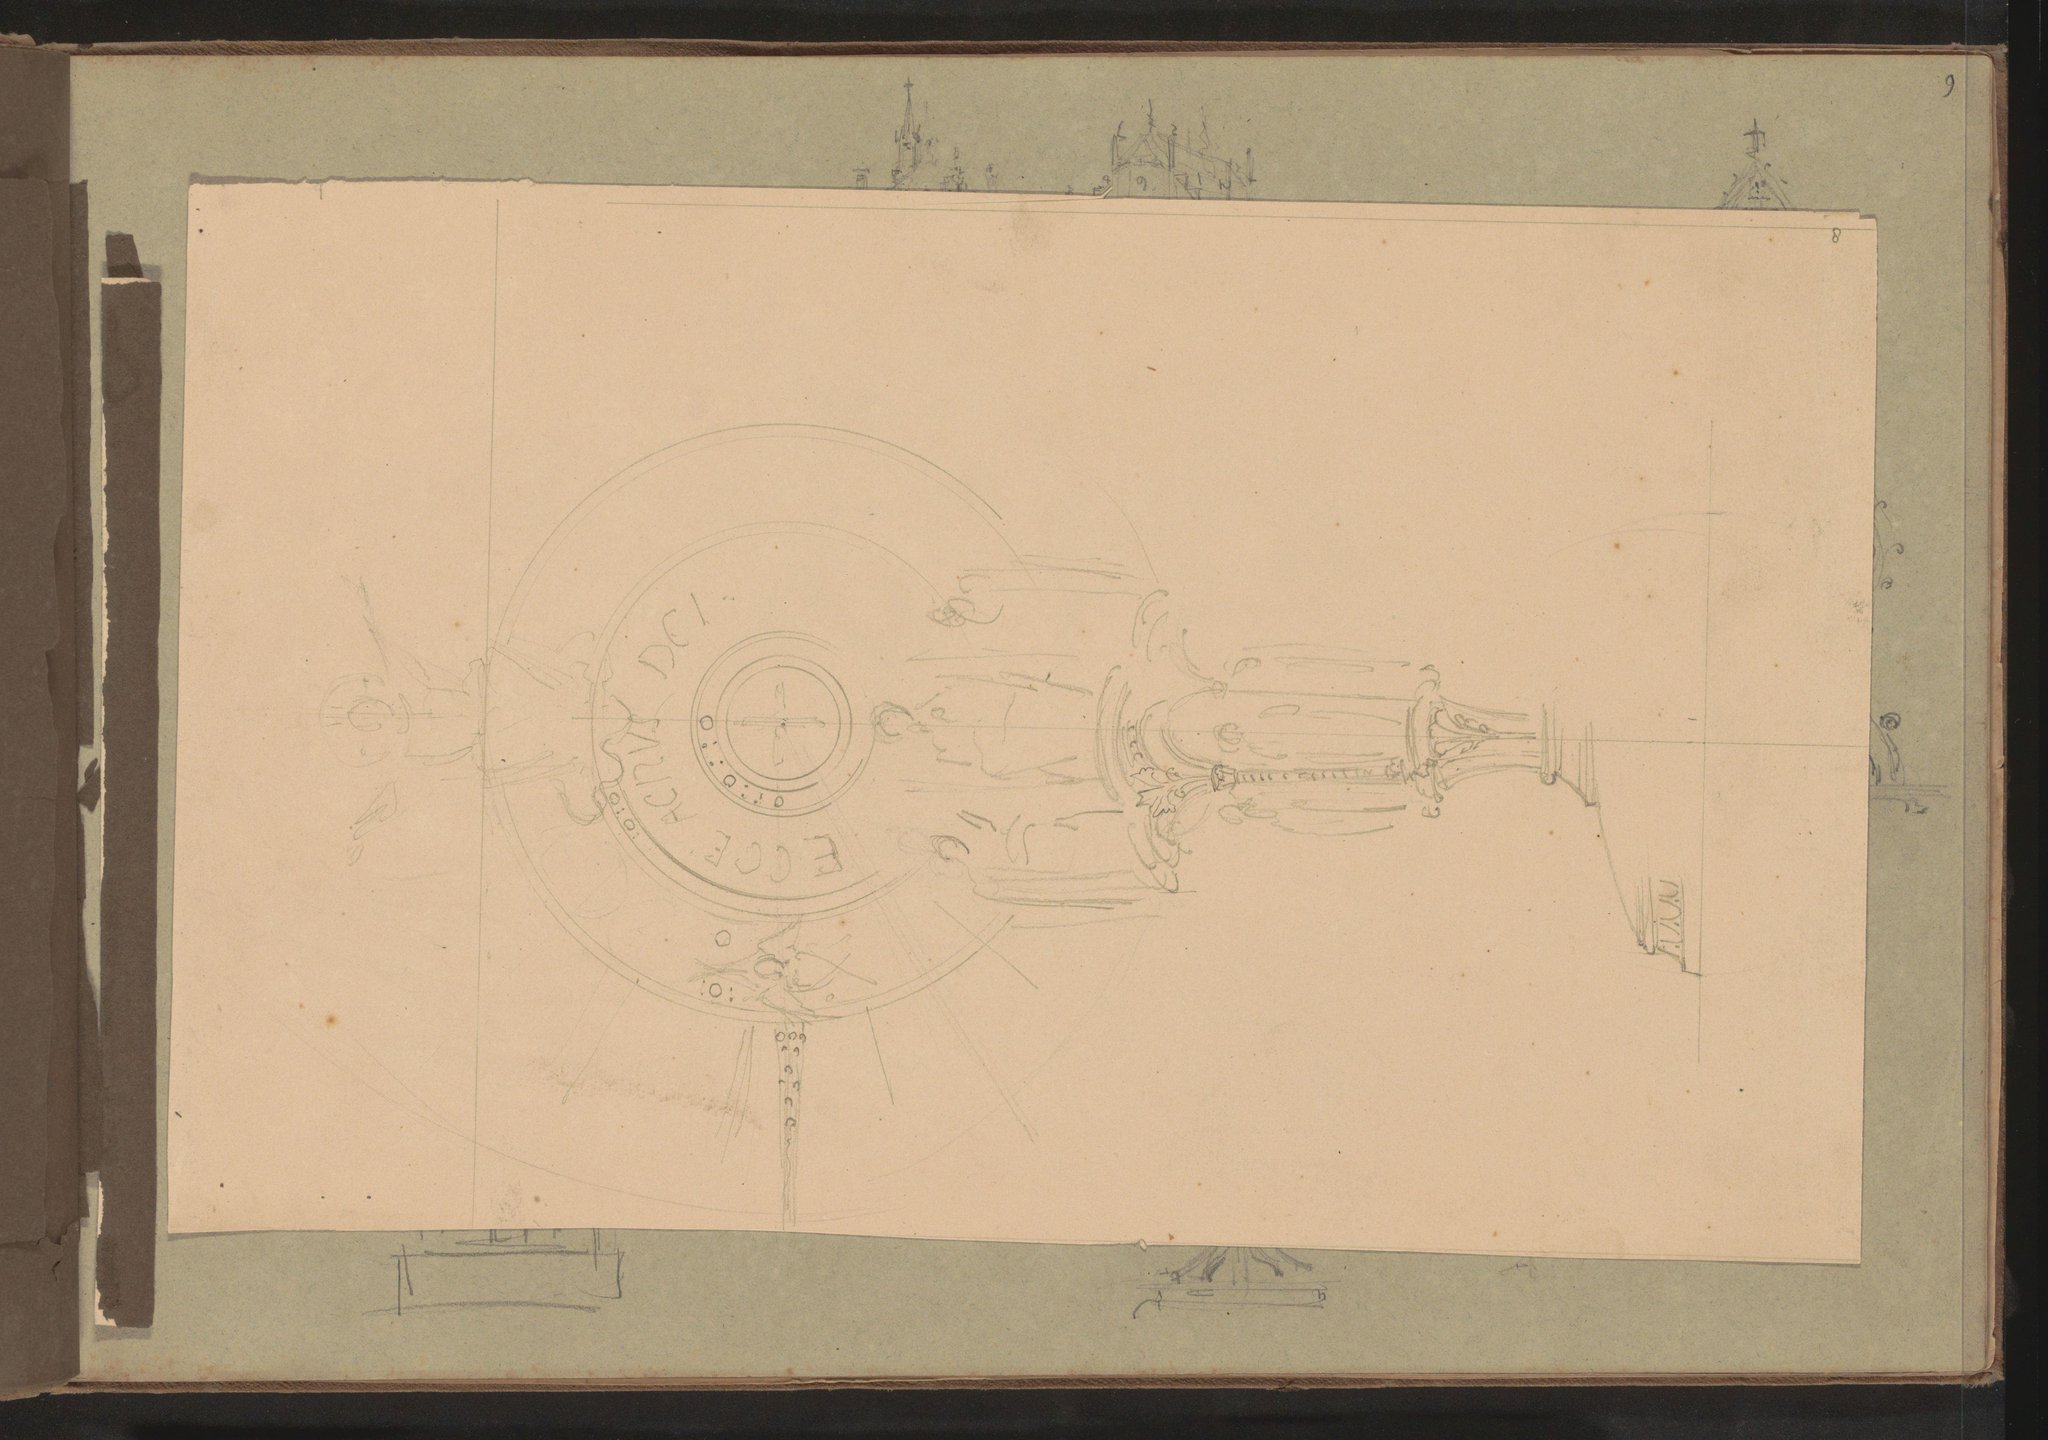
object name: sketchbook leaf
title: Monstrans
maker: pierre joseph hubert cuypers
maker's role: draughtsman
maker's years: 1827-1921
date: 1837-1921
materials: paper, pencil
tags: ostensorium, monstrance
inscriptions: annotation: ‘ECCE AGNUS DEI’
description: Los blad van kleiner formaat in het schetsboek.